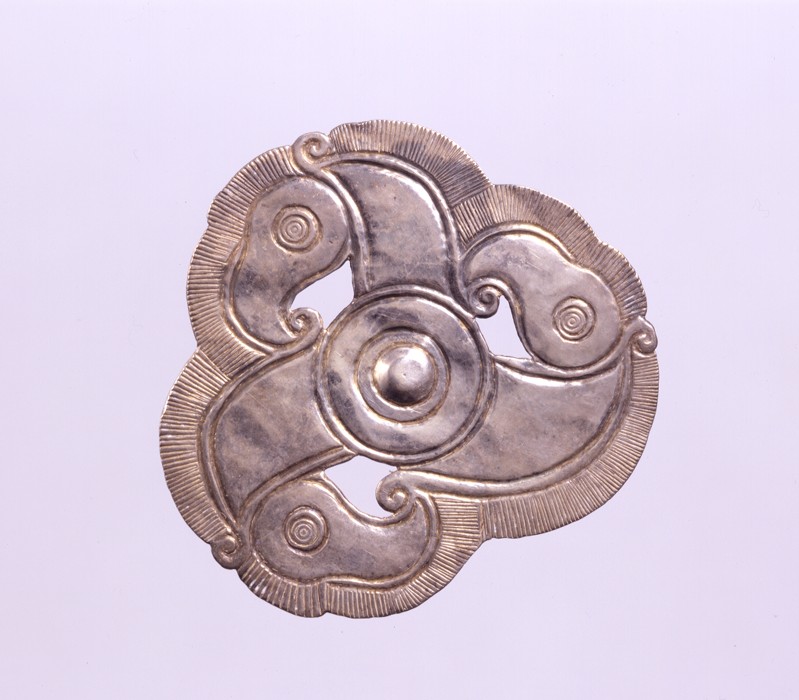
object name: harness ornament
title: Harness Ornament with Raptors and Carnivores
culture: bulgarian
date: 434-301 BCE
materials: silver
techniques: gilding